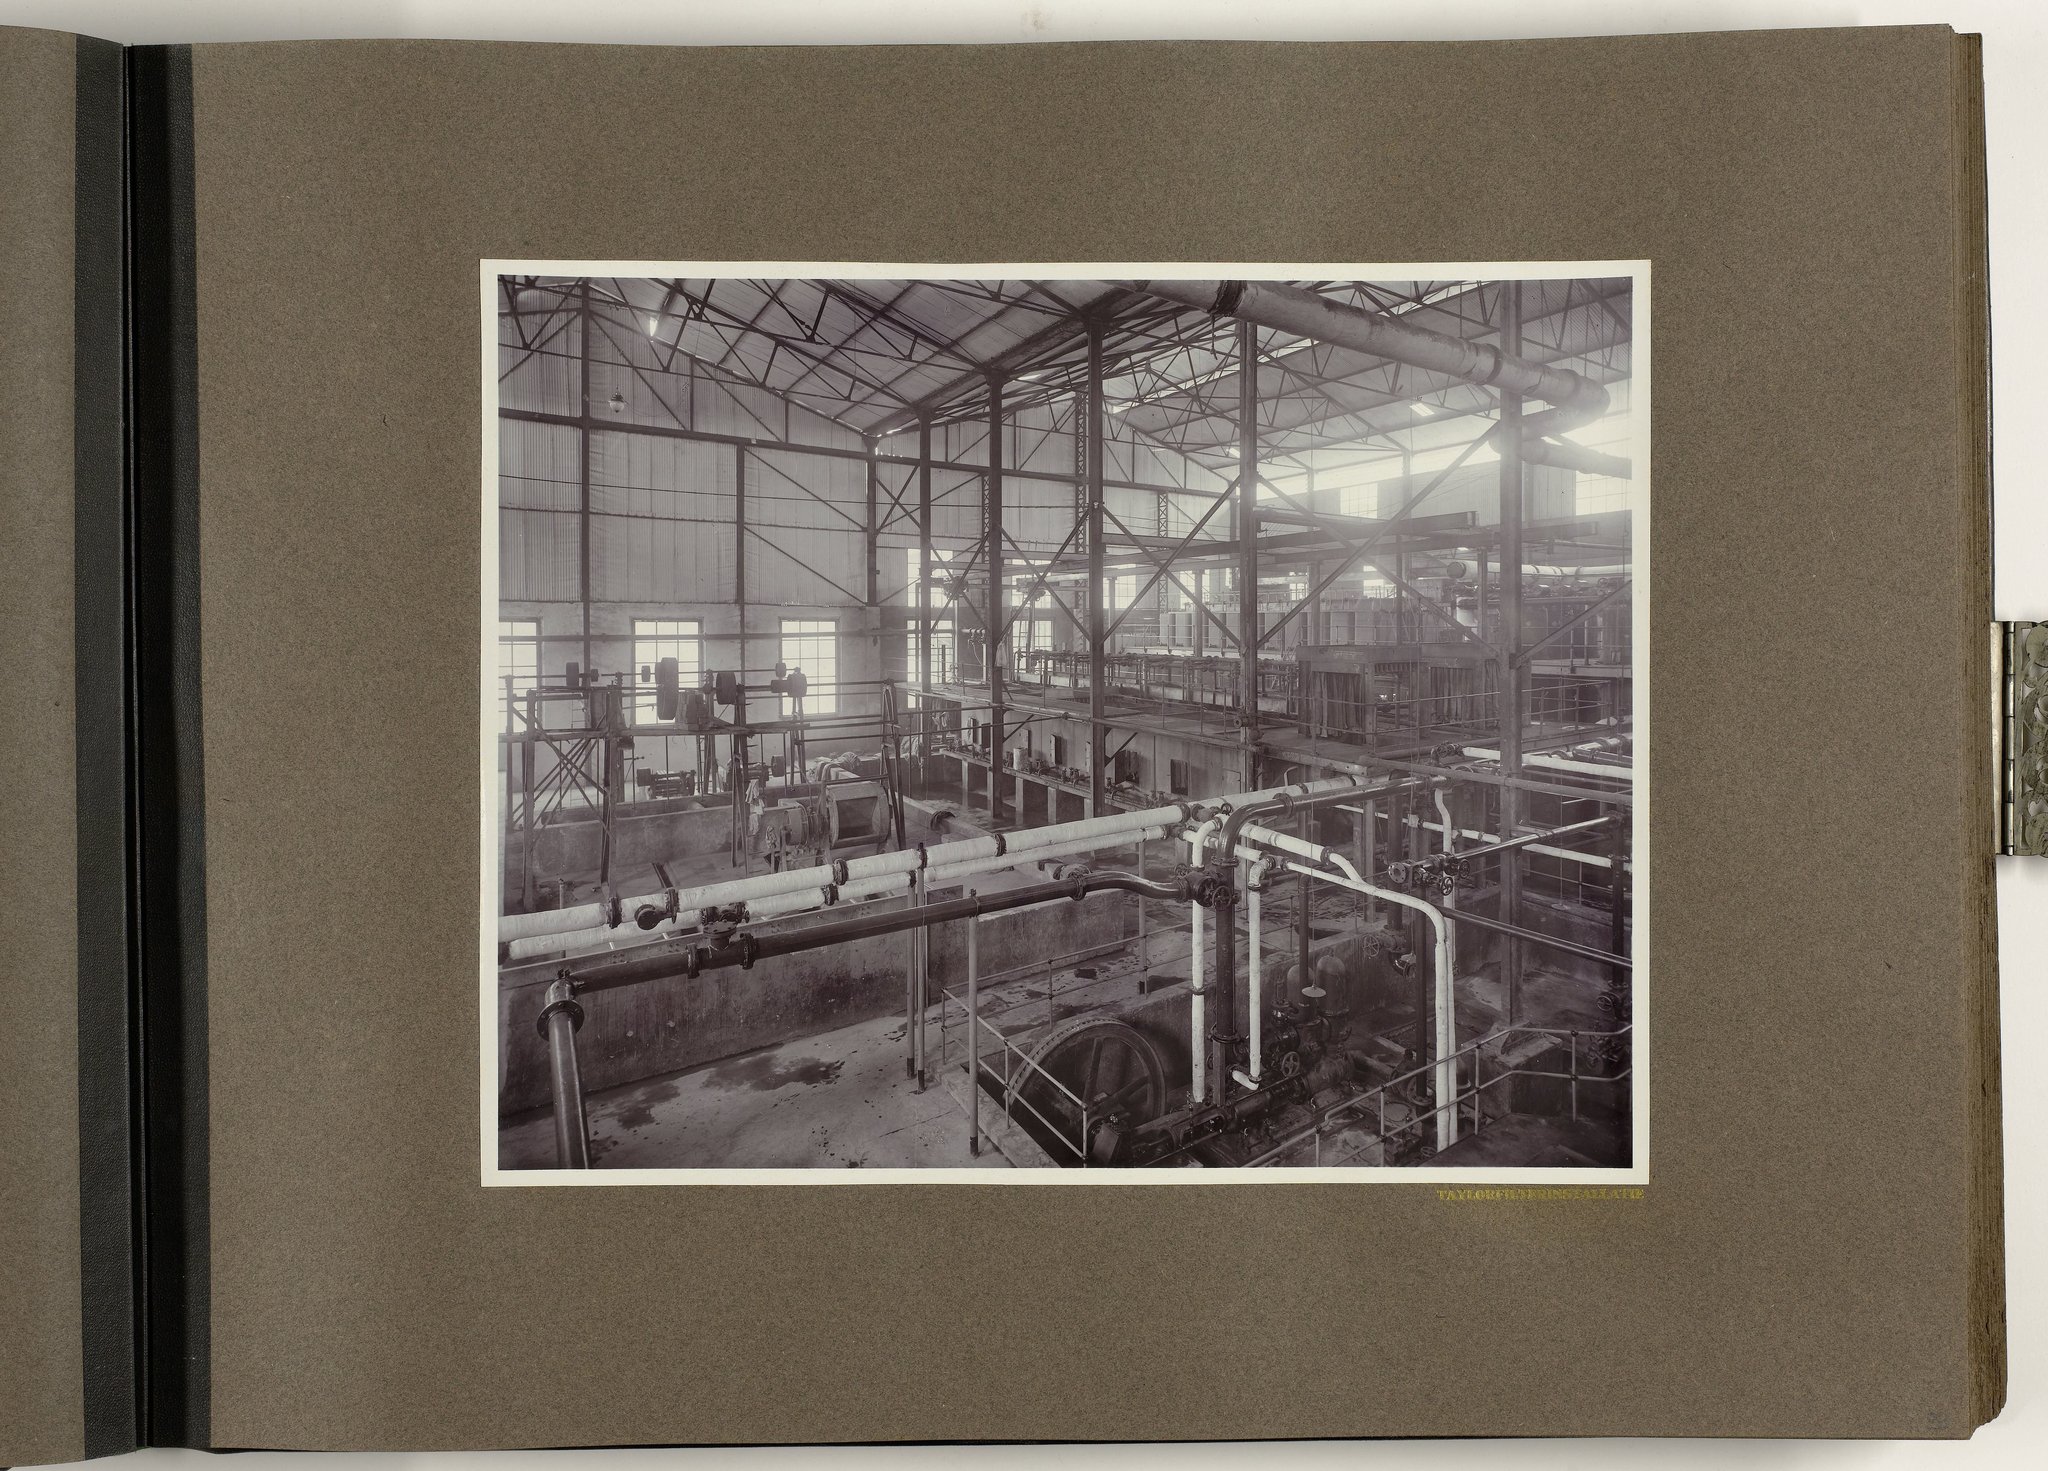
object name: photograph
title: Taylorfilteringsinstallatie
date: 1917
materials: photographic support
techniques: gelatin silver print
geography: jatiroto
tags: colonial system, (non-fruit) products of plants or trees: sugarcane, interior of industrial structures (regardless of the materials processed or the products made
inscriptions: inscription: ‘TAYLORFILTERINGSINSTALLATIE’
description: Filterinstallatie in de suikerfabriek. Onderdeel van het fotoalbum aangeboden aan F.J. Wirix door het personeel van de Suikeronderneming Djatiroto in 1917.